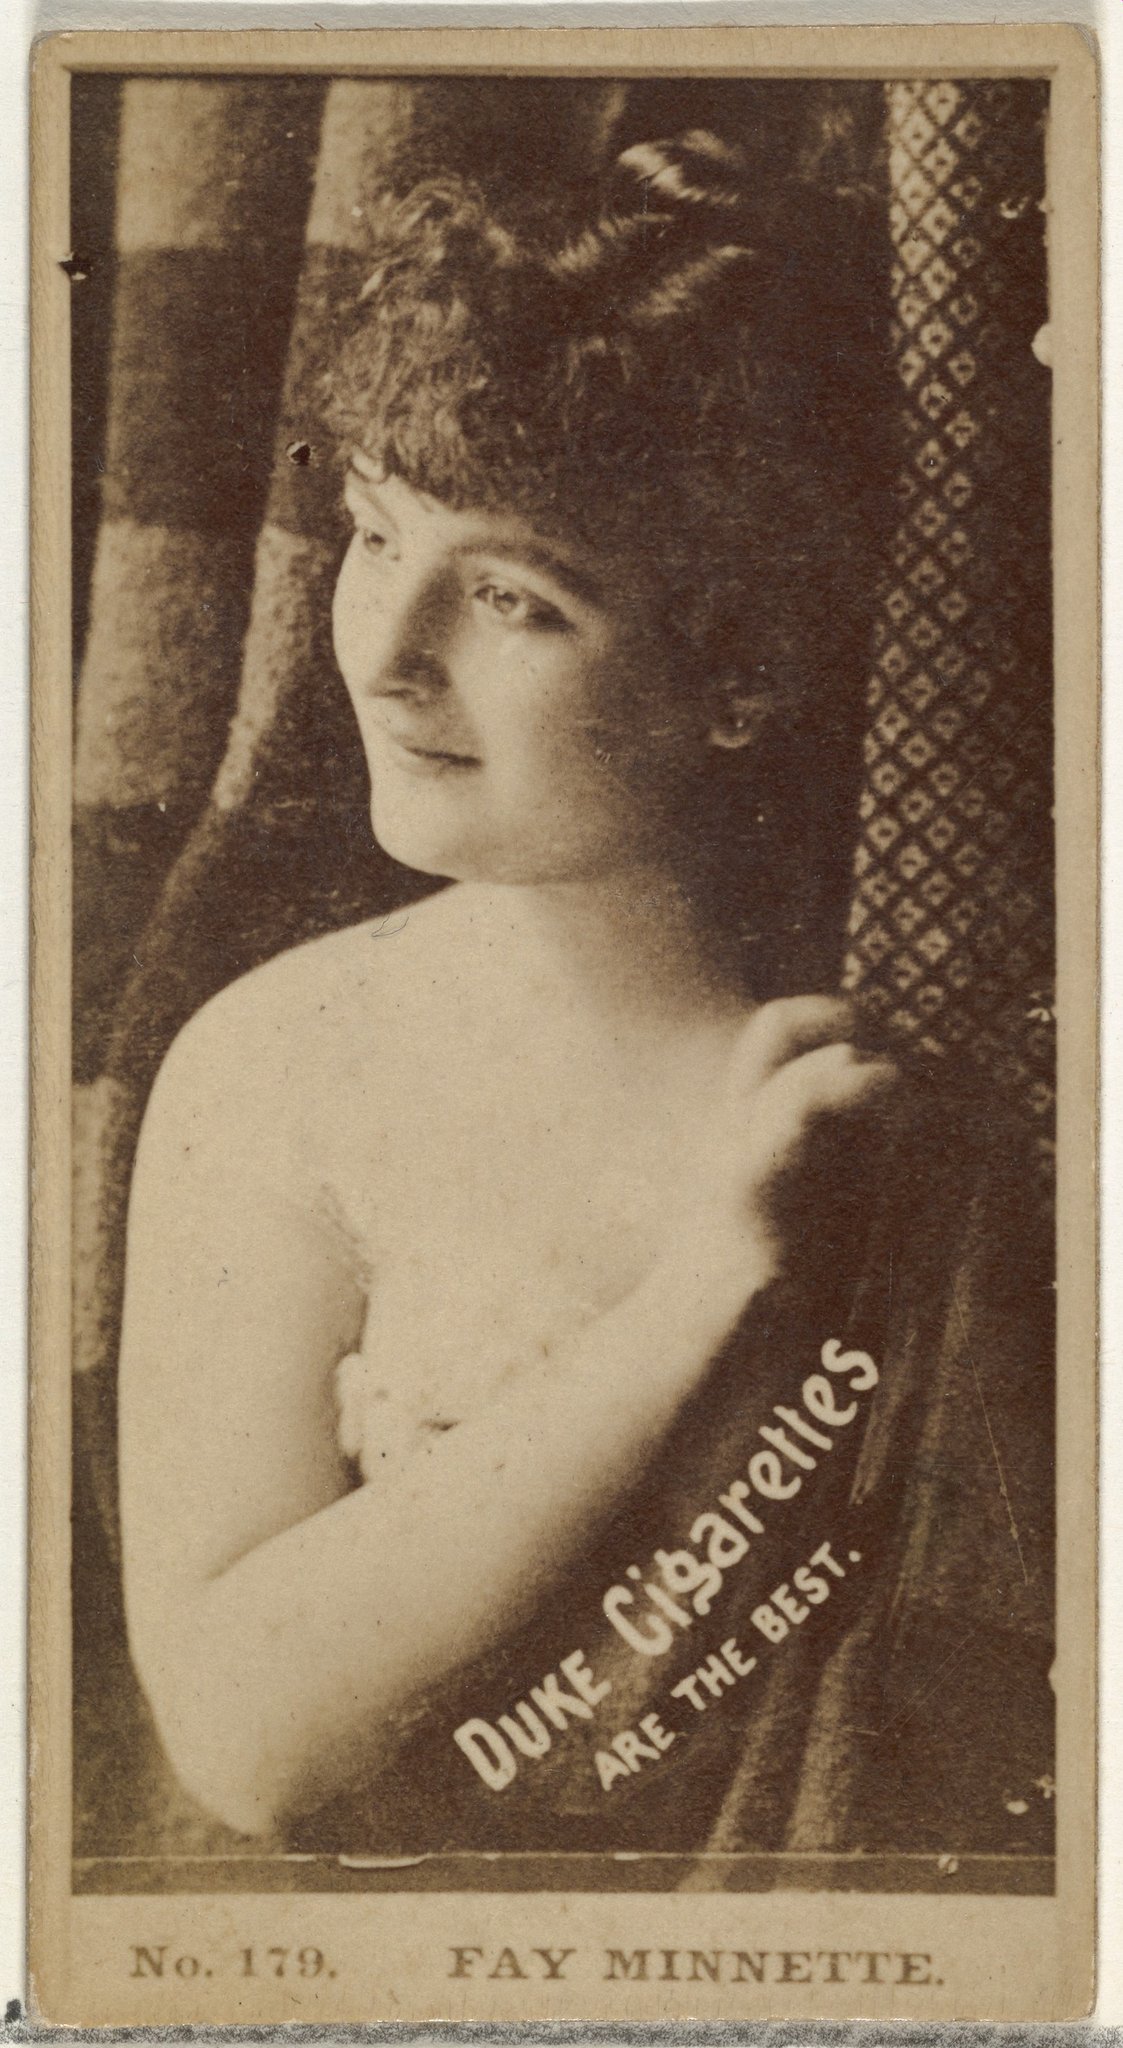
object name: photograph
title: Card Number 179, Fay Minnette, from the Actors and Actresses series (N145-6) issued by Duke Sons & Co. to promote Duke Cigarettes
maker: w. duke, sons & co.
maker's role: publisher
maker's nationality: american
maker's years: 1870-1920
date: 1880-1889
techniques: albumen silver print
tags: portraits,women,actresses